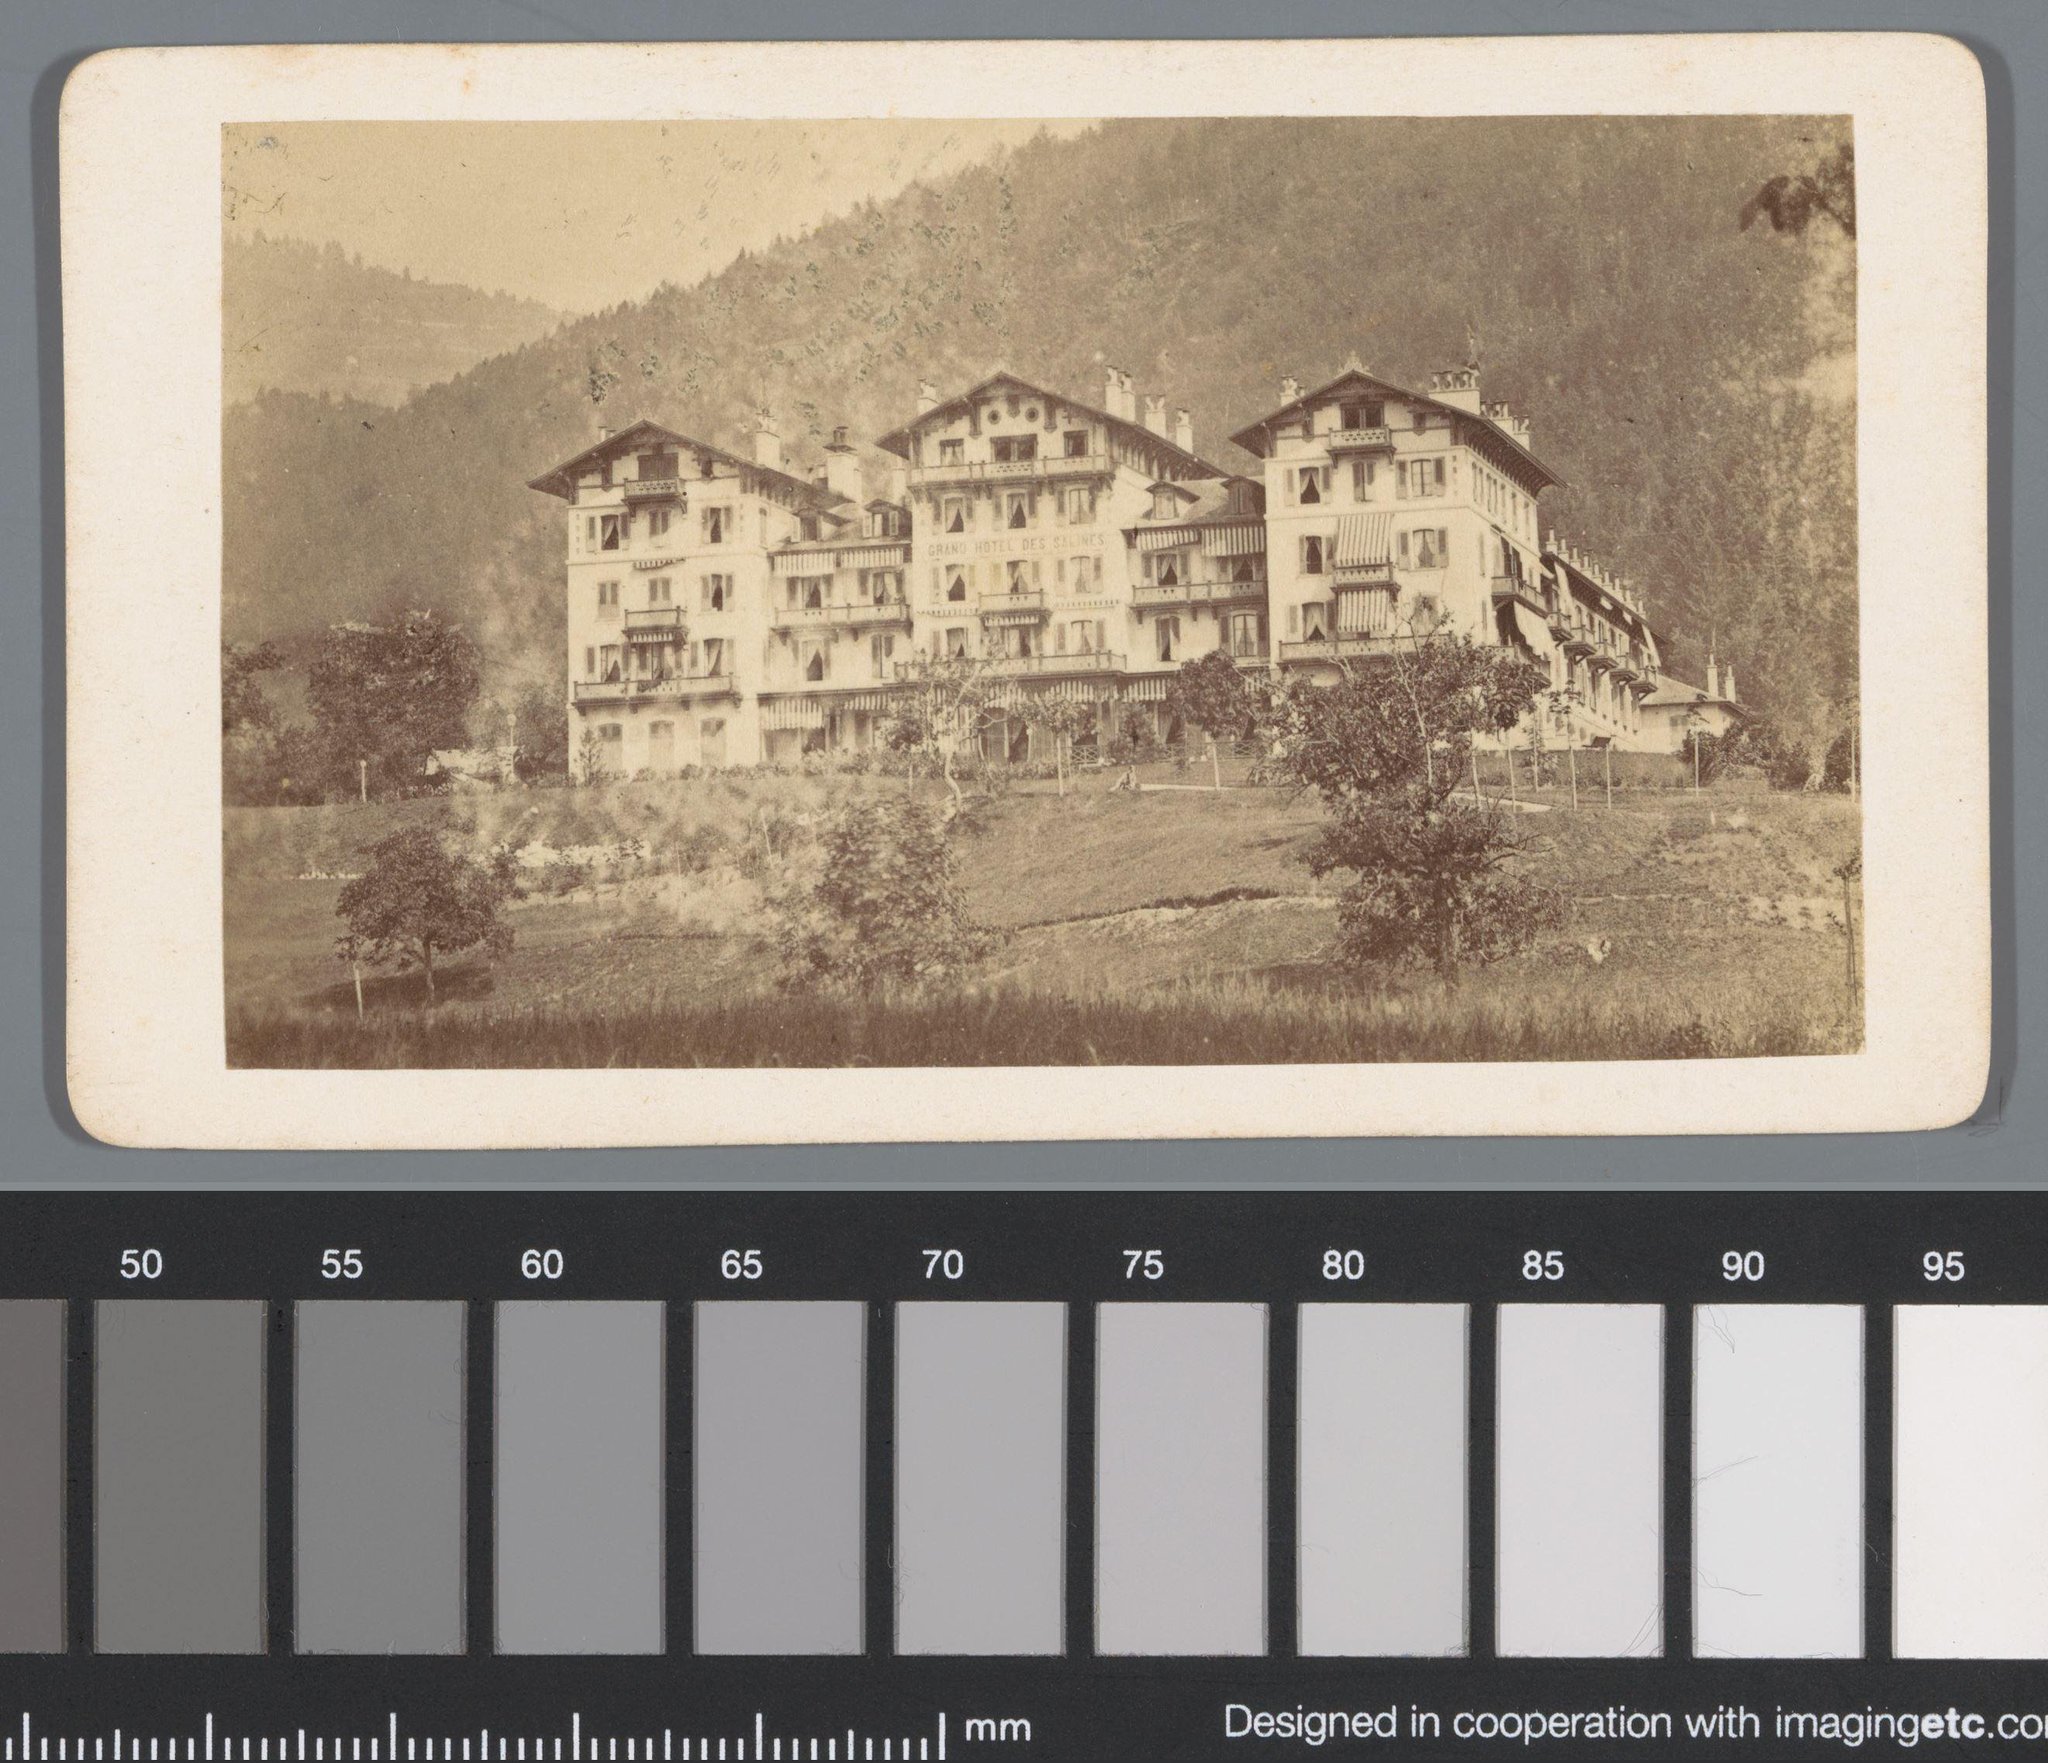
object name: carte de visite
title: Grand Hôtel des Salines in Bex, Zwitserland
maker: Anonymous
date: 1869-1885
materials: cardboard, paper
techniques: albumen print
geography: bex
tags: exterior ~ representation of a building, hotel, hostelry, inn